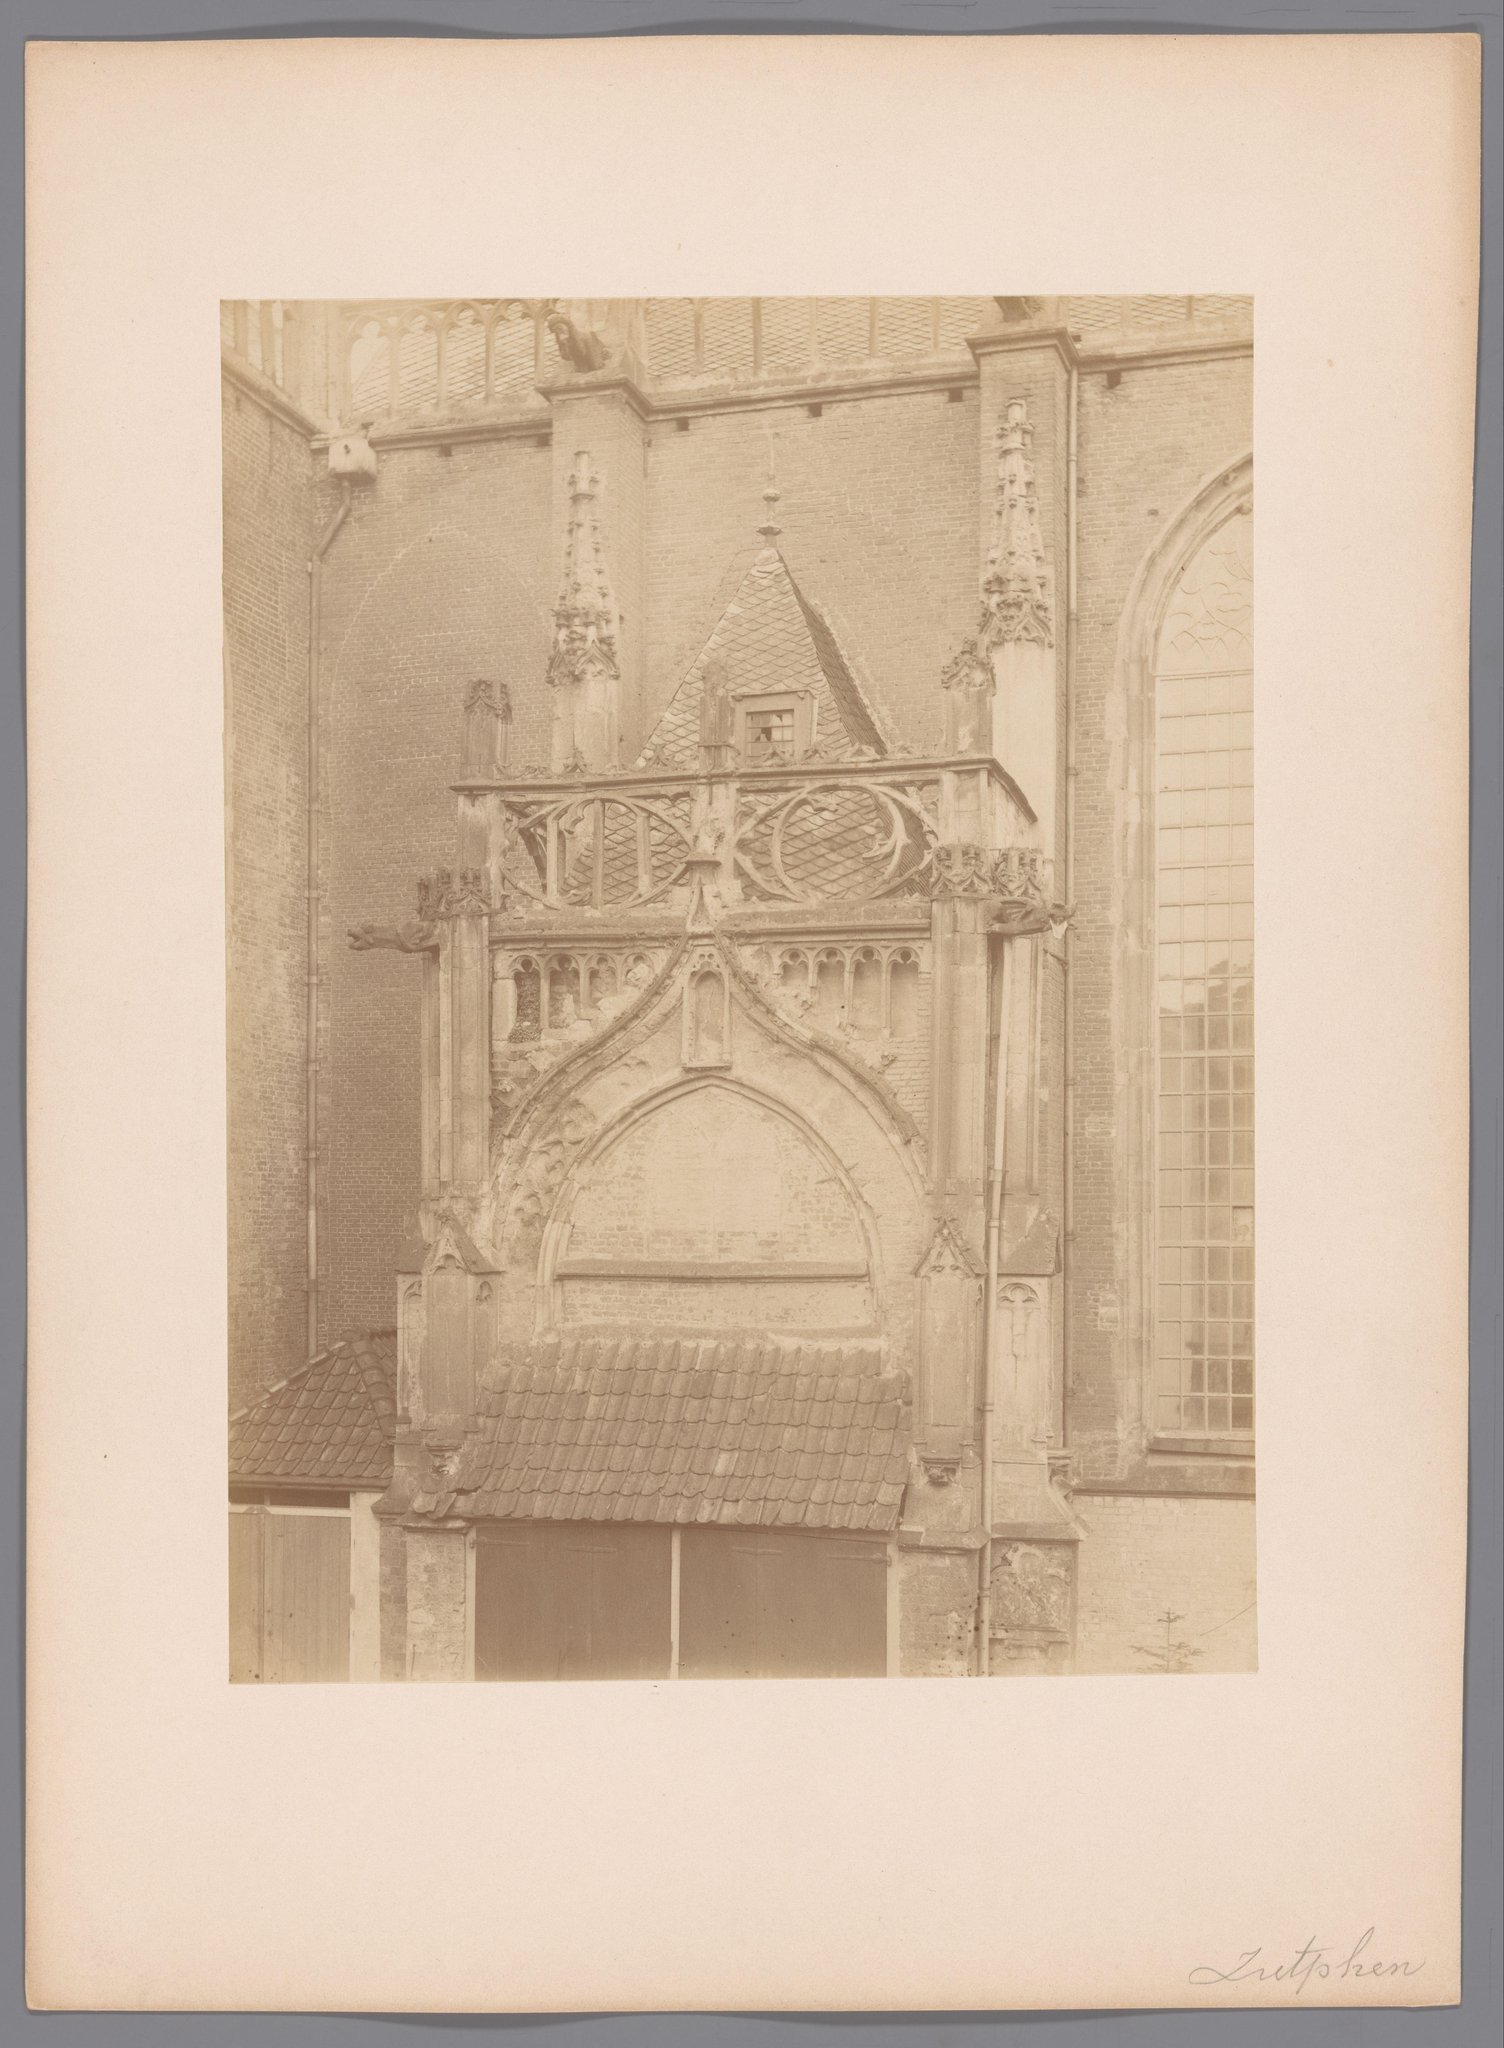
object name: photograph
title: Noordelijk portaal van de Sint Walburgiskerk te Zutphen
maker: anoniem (monumentenzorg)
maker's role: fotograaf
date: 1890-1910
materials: cardboard, photographic support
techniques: albumen print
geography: zutphen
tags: parts of church exterior and annexes: portal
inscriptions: annotation: ‘Zutphen’, annotation: ‘Zutphen/ N.H. Kerk/ N. portaal’